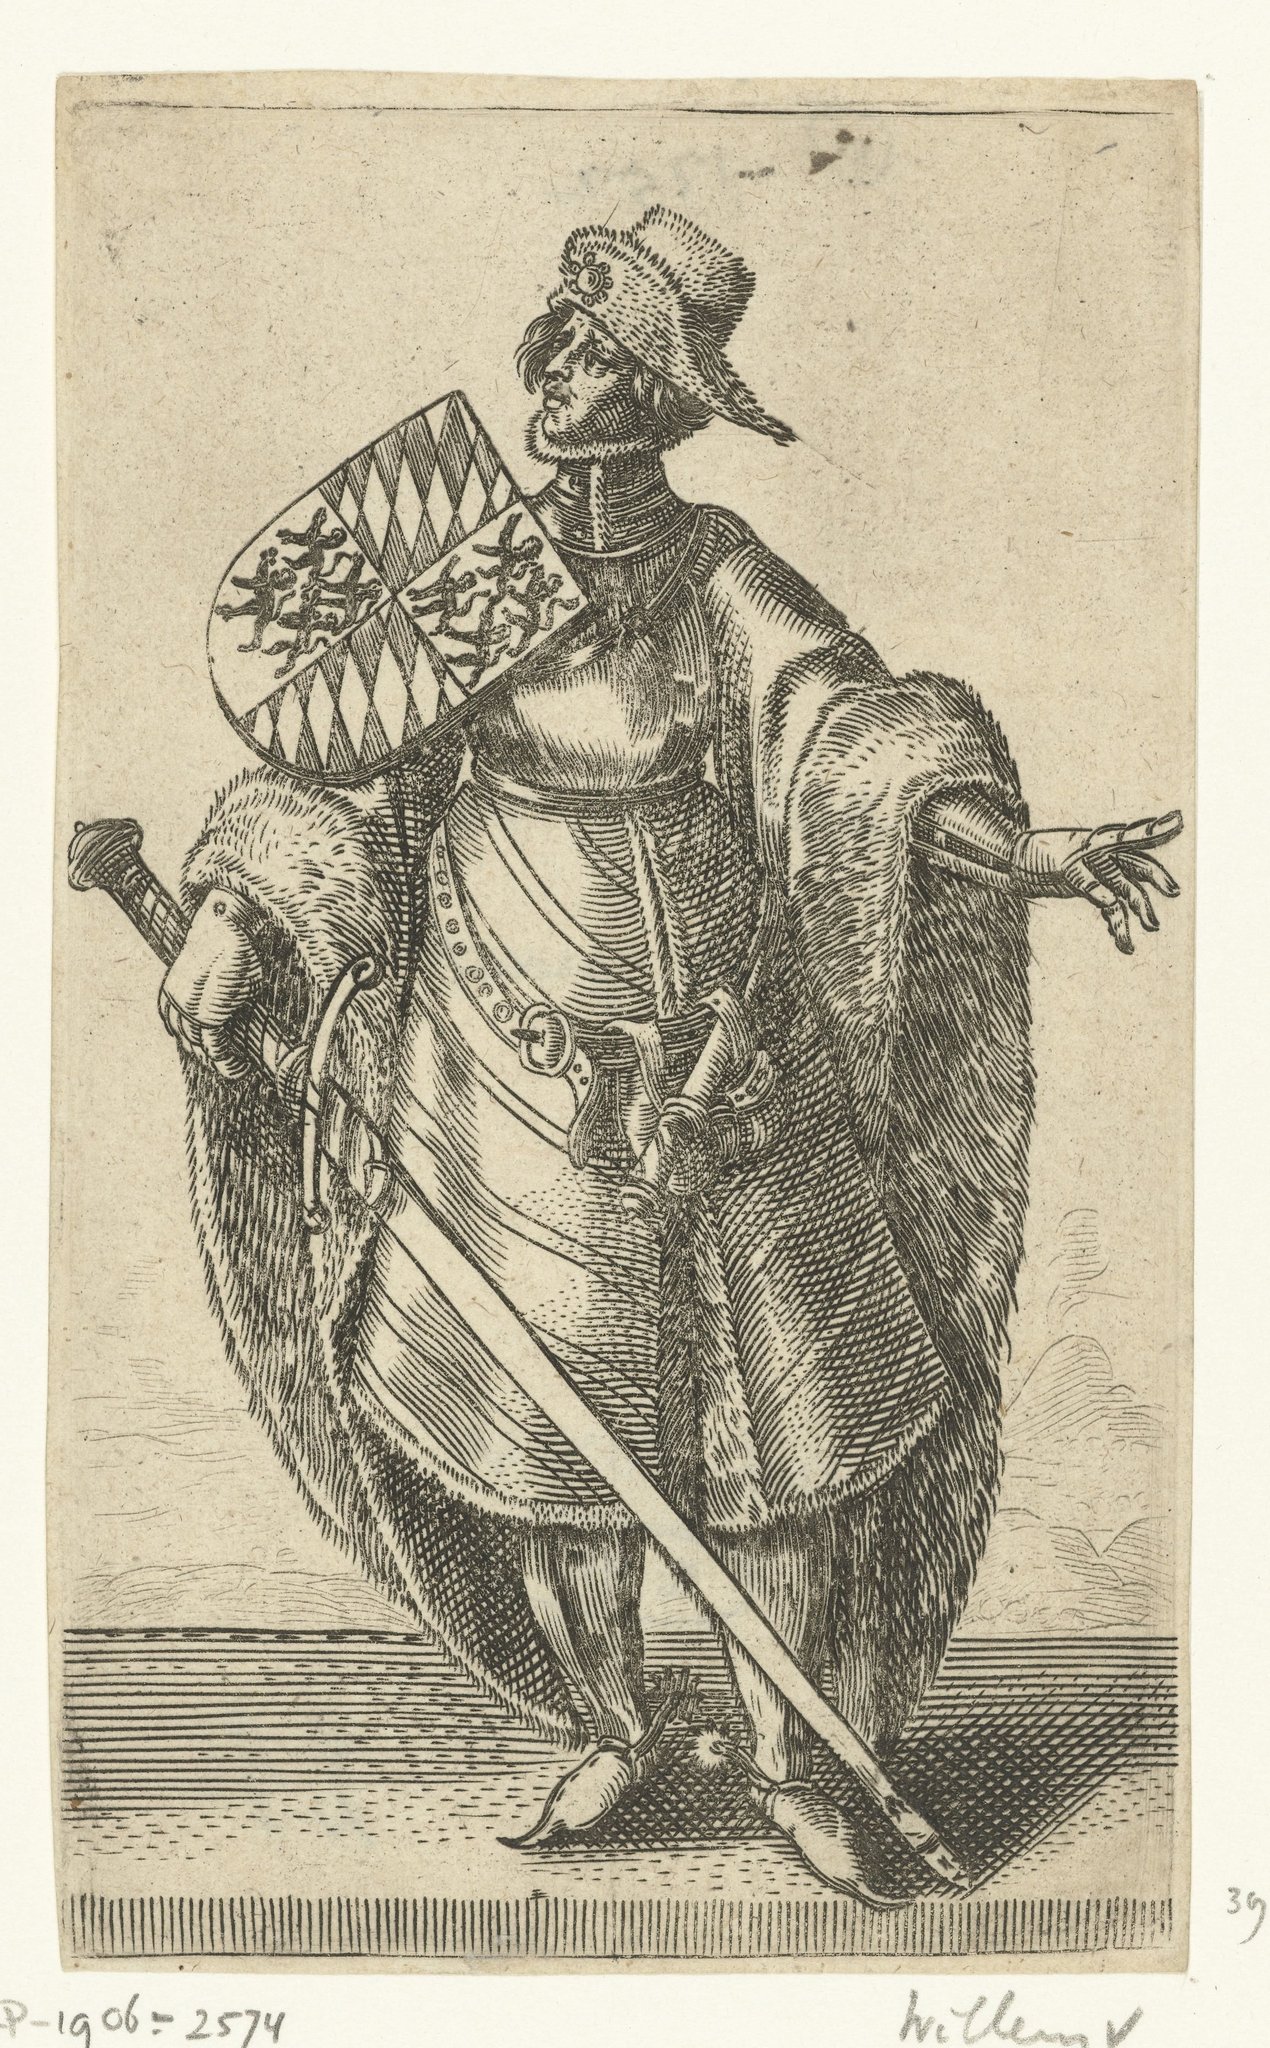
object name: print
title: Graven en gravinnen van Holland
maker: adriaen matham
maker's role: draughtsman, print maker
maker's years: 1599-1660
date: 1620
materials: paper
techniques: engraving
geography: haarlem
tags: earl, willem v van holland (graaf van holland en zeeland), nobility and patriciate; chivalry, knighthood, county of holland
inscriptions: collector's mark: Lugt 2228, name: ‘willem de 5de/ 21ste graaf’, number: ‘1352’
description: Portret van Willem V van Holland, graaf van Holland en Zeeland, staande in een harnas met op zijn schouder een wapenschild en in zijn hand een zwaard. Prent uit een serie van 36 prenten met portretten ten voeten uit van graven en gravinnen van Holland.